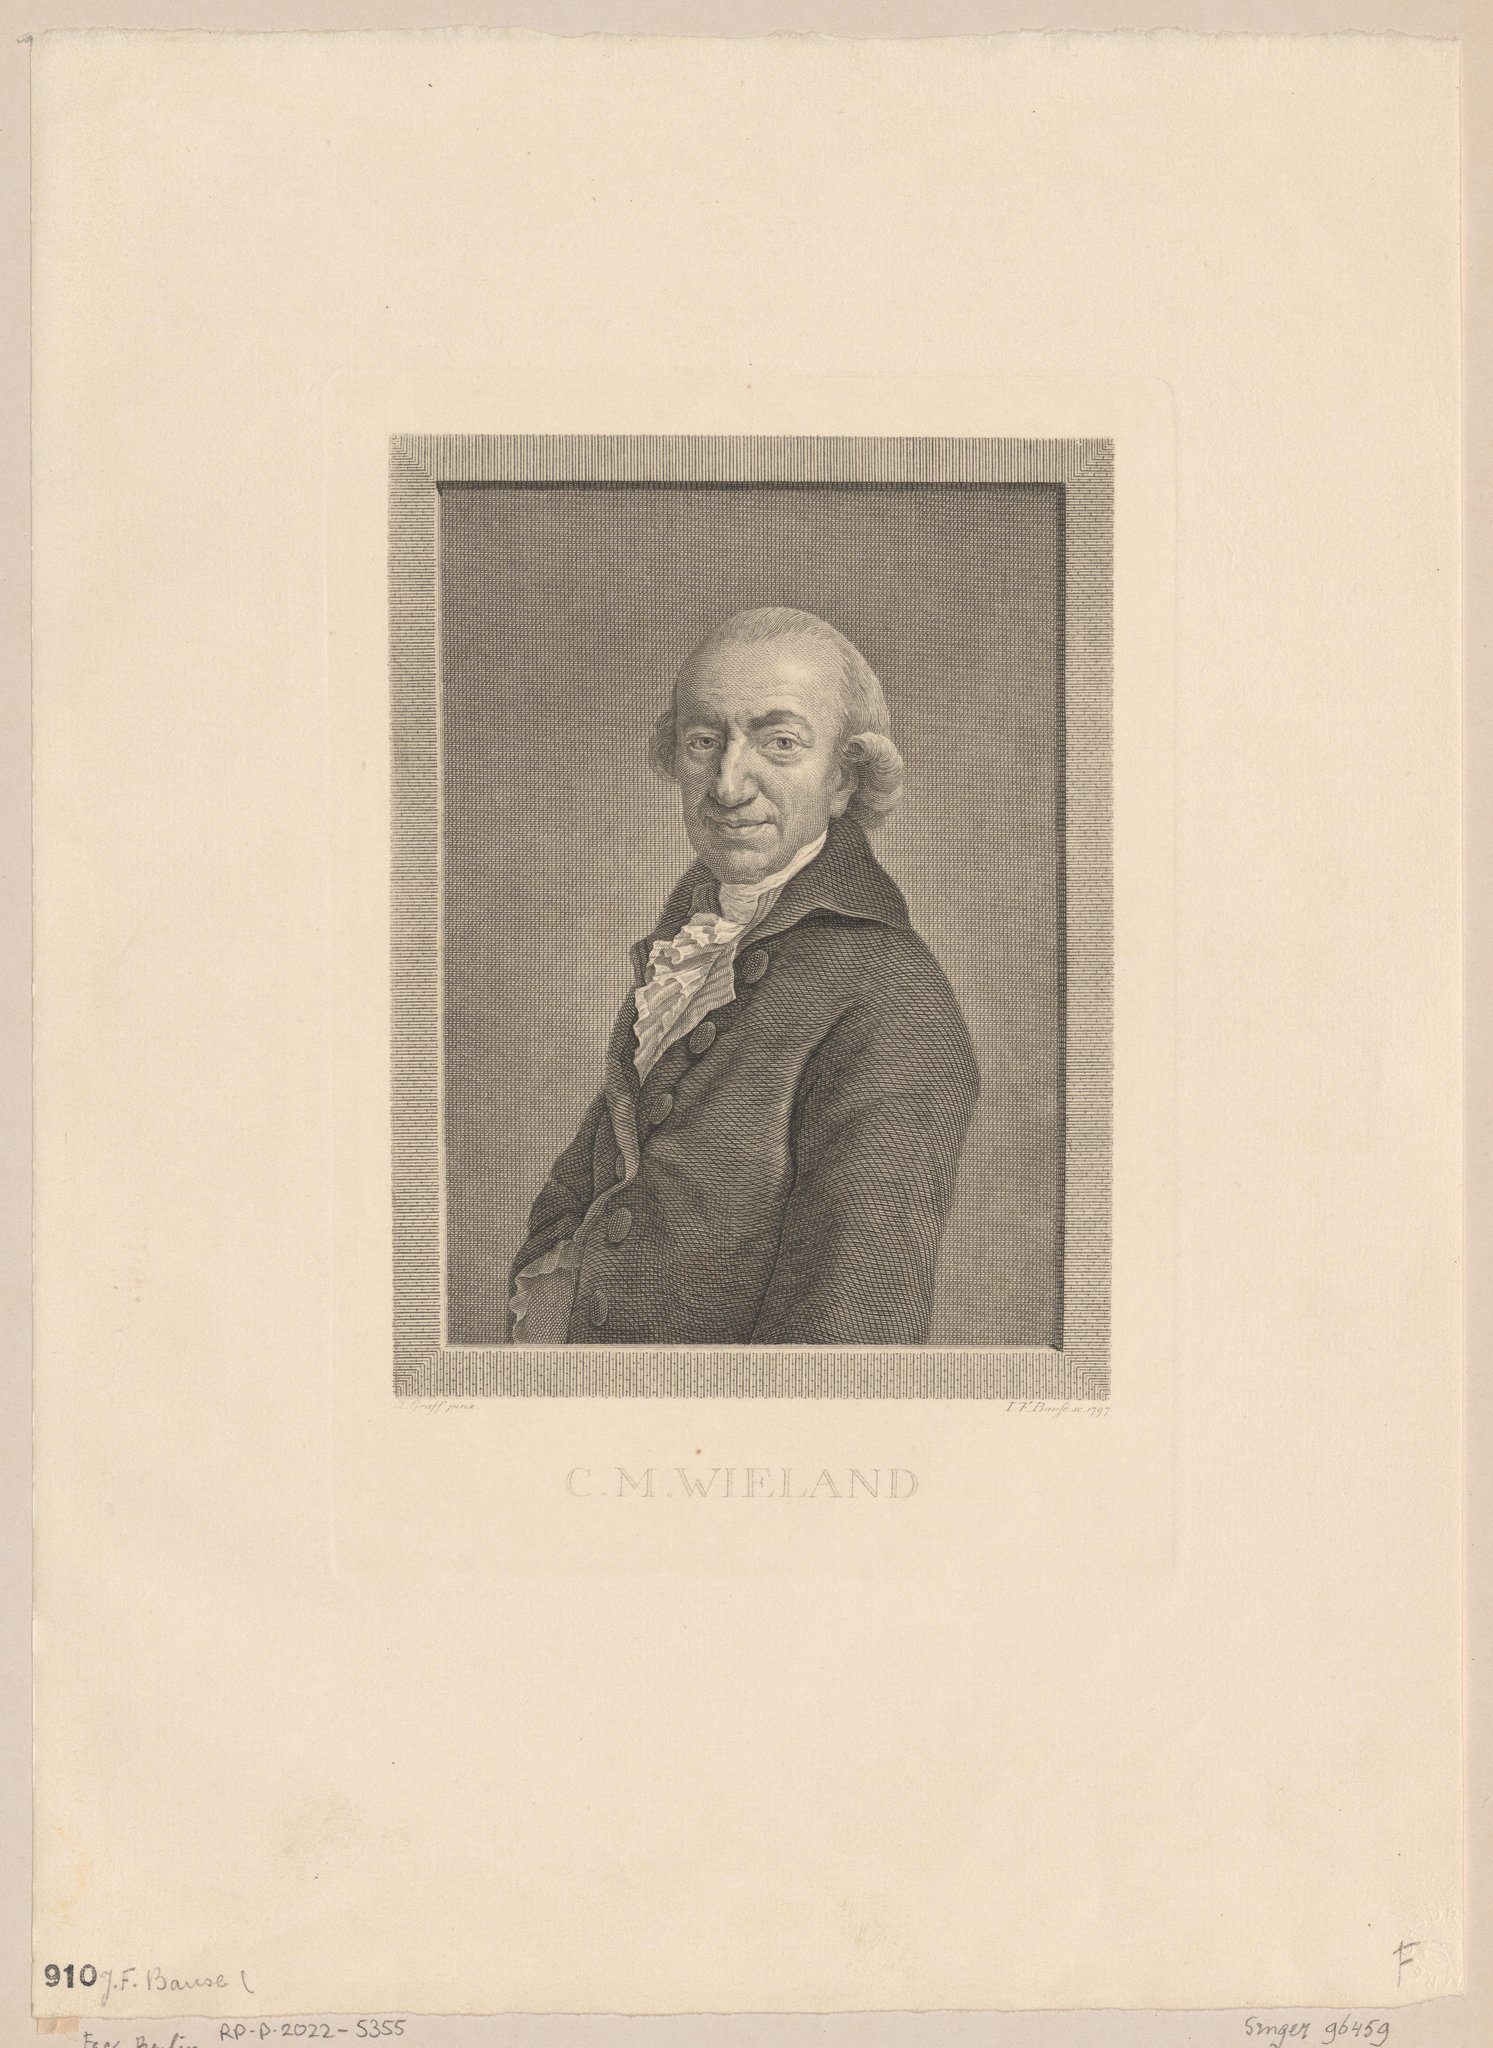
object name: photomechanical print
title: Portret van Christoph Martin Wieland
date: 1928-1949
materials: paper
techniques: blind stamped, photograph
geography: berlin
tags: publisher, christoph martin wieland, historical persons, portrait of a writer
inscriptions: stamp: ‘910’, stamp: Lugt 4925, check stamp: Lugt 4924